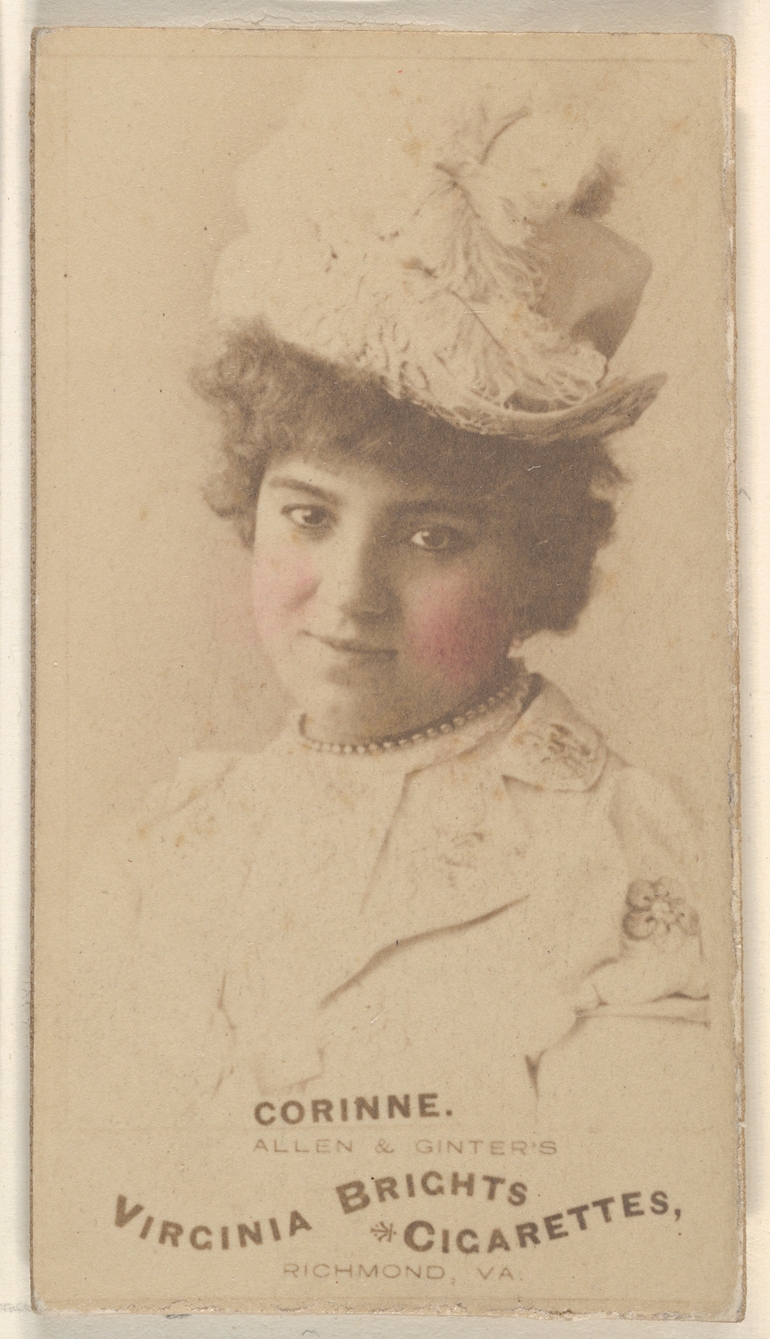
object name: photograph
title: Corinne, from the Actors and Actresses series (N45, Type 1) for Virginia Brights Cigarettes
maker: allen & ginter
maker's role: publisher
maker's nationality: american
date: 1888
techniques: albumen silver print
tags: portraits,women,actresses